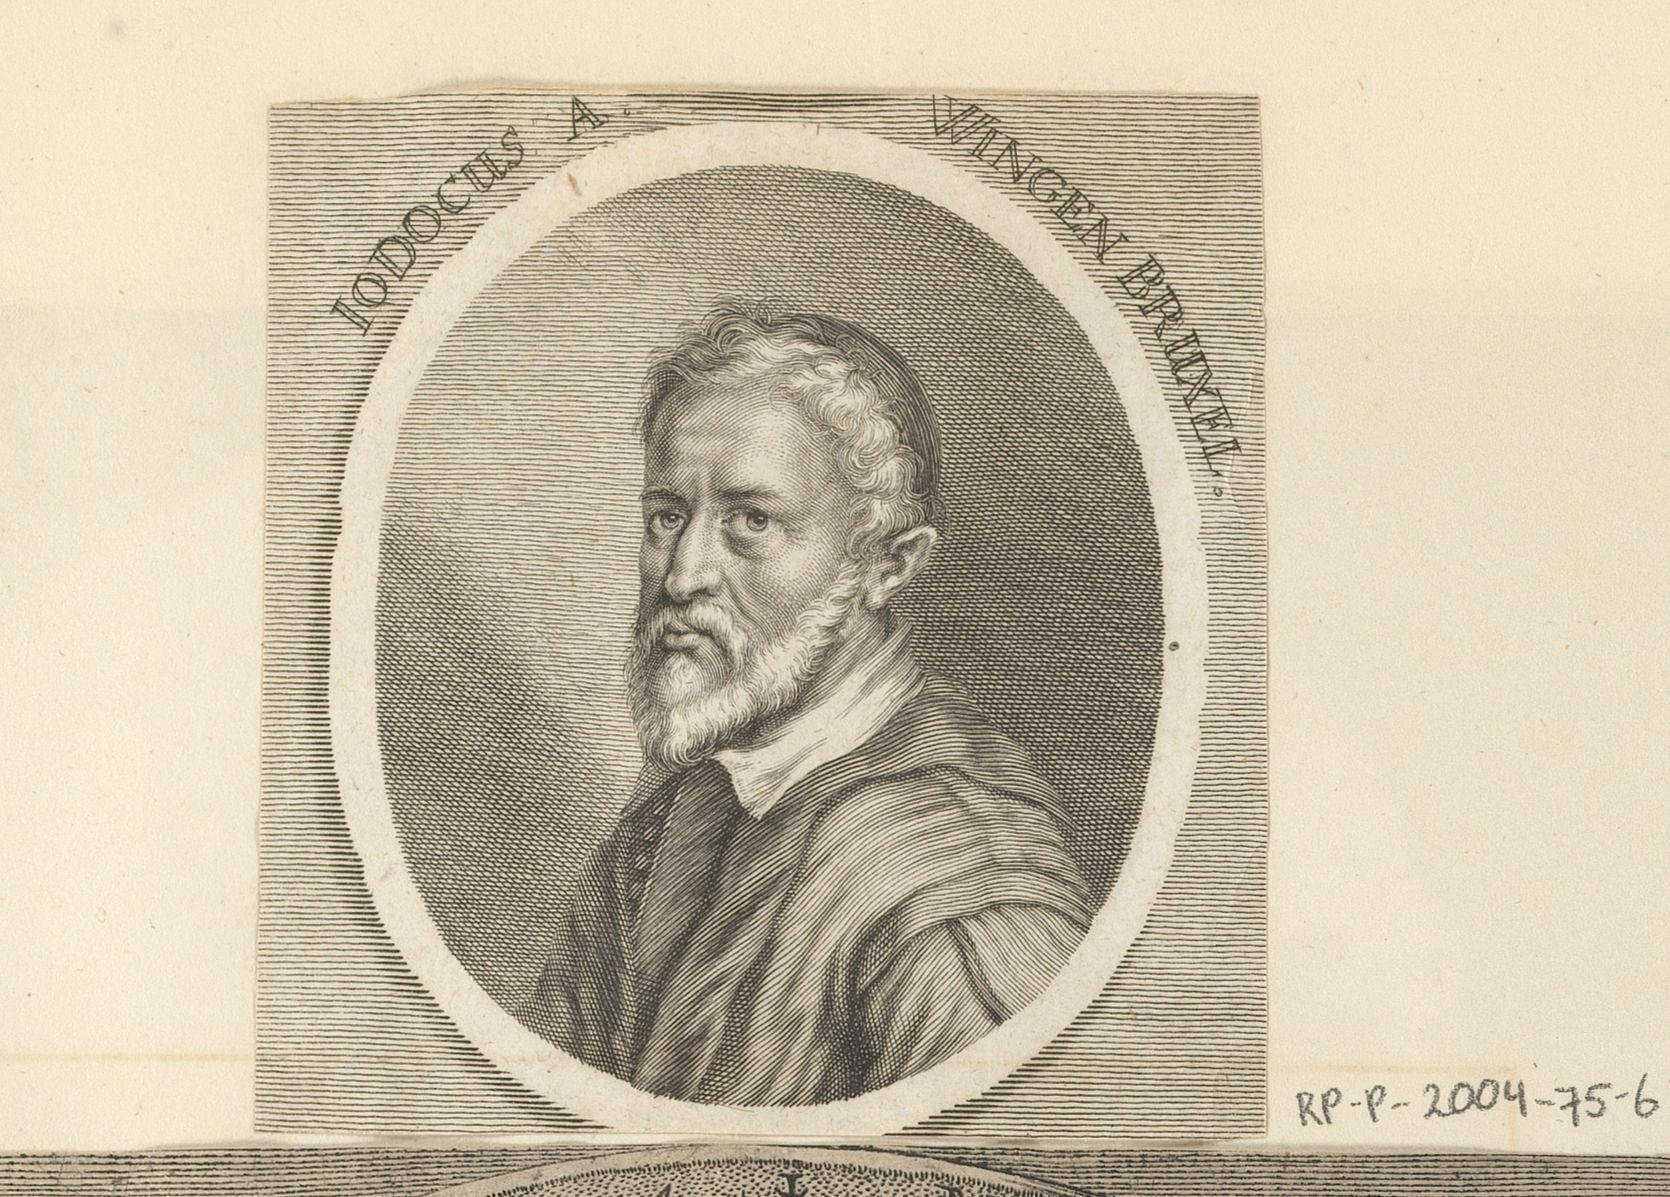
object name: album leaf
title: Portret van Joos van Winghe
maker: johann georg waldreich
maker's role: print maker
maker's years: -1680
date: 1768-1775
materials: paper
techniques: engraving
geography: nuremberg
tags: painter, draughtsman, joos van winghe, historical persons, portrait, self-portrait of painter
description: Prent uit: Sandrart, Joachim von. Teutsche Academie der Bau- Bildhauer- und Maler-Kunst: worinn die Regeln und Lehrsätze dieser Künste gegeben. 14 dln. Neurenberg: erven Johann Andreas Endter, [1774], dl. 7, p. DD. De samensteller heeft deze prent in het album geplakt als illustratie bij: Pilkington, Matthew en Johann Heinrich Füssli. A dictionary of painters, from the revival of the art to the present period. 4 dln. Londen: John Crowder, 1805, dl. 4, p. 649.